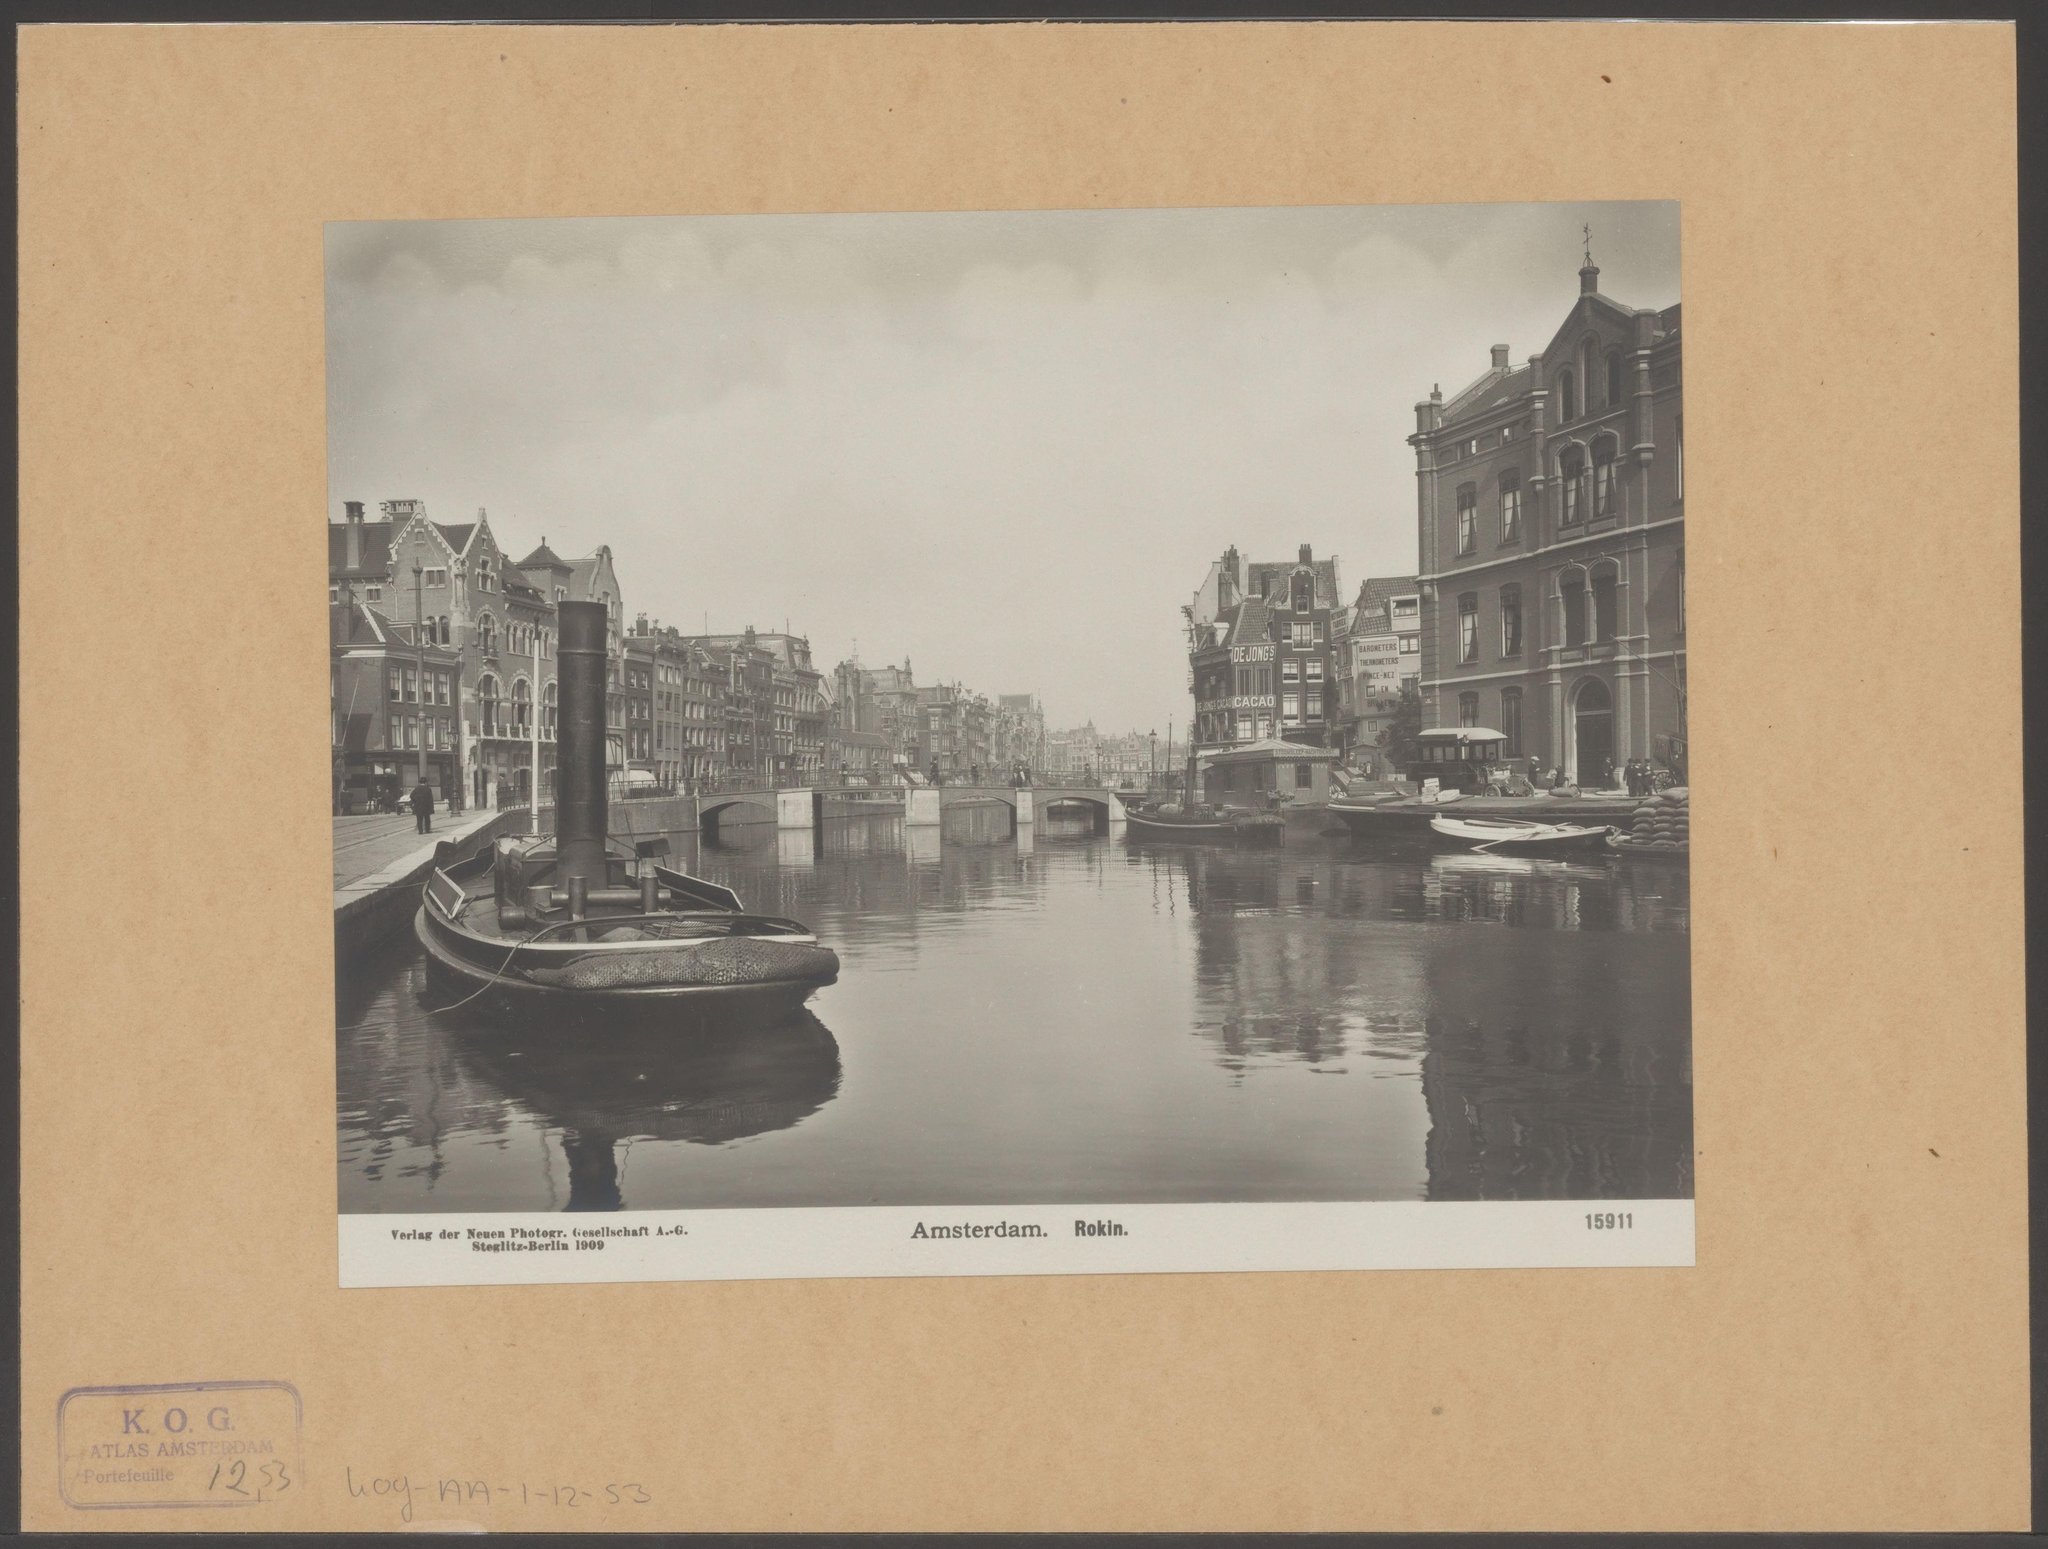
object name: photograph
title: Gezicht op het Rokin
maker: Anonymous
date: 1909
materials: paper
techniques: gelatin silver print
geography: germany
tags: city-view in general; 'veduta', canal, bridge in city across river, canal, etc.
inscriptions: collector's mark: ‘12-53’ Lugt 1641b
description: Onderwerpsrubriek binnen de Atlas Amsterdam: Rokin, Rotterdammersloot, Rozengang, Rozengracht, Rozenstraat, Rusland, Rustenburgerstraat, Ruysdaelkade, Ruysdaelstraat, Ruyterkade (de), Ruyterweg (Admiraal de). Genummerd rechtsboven: 5.